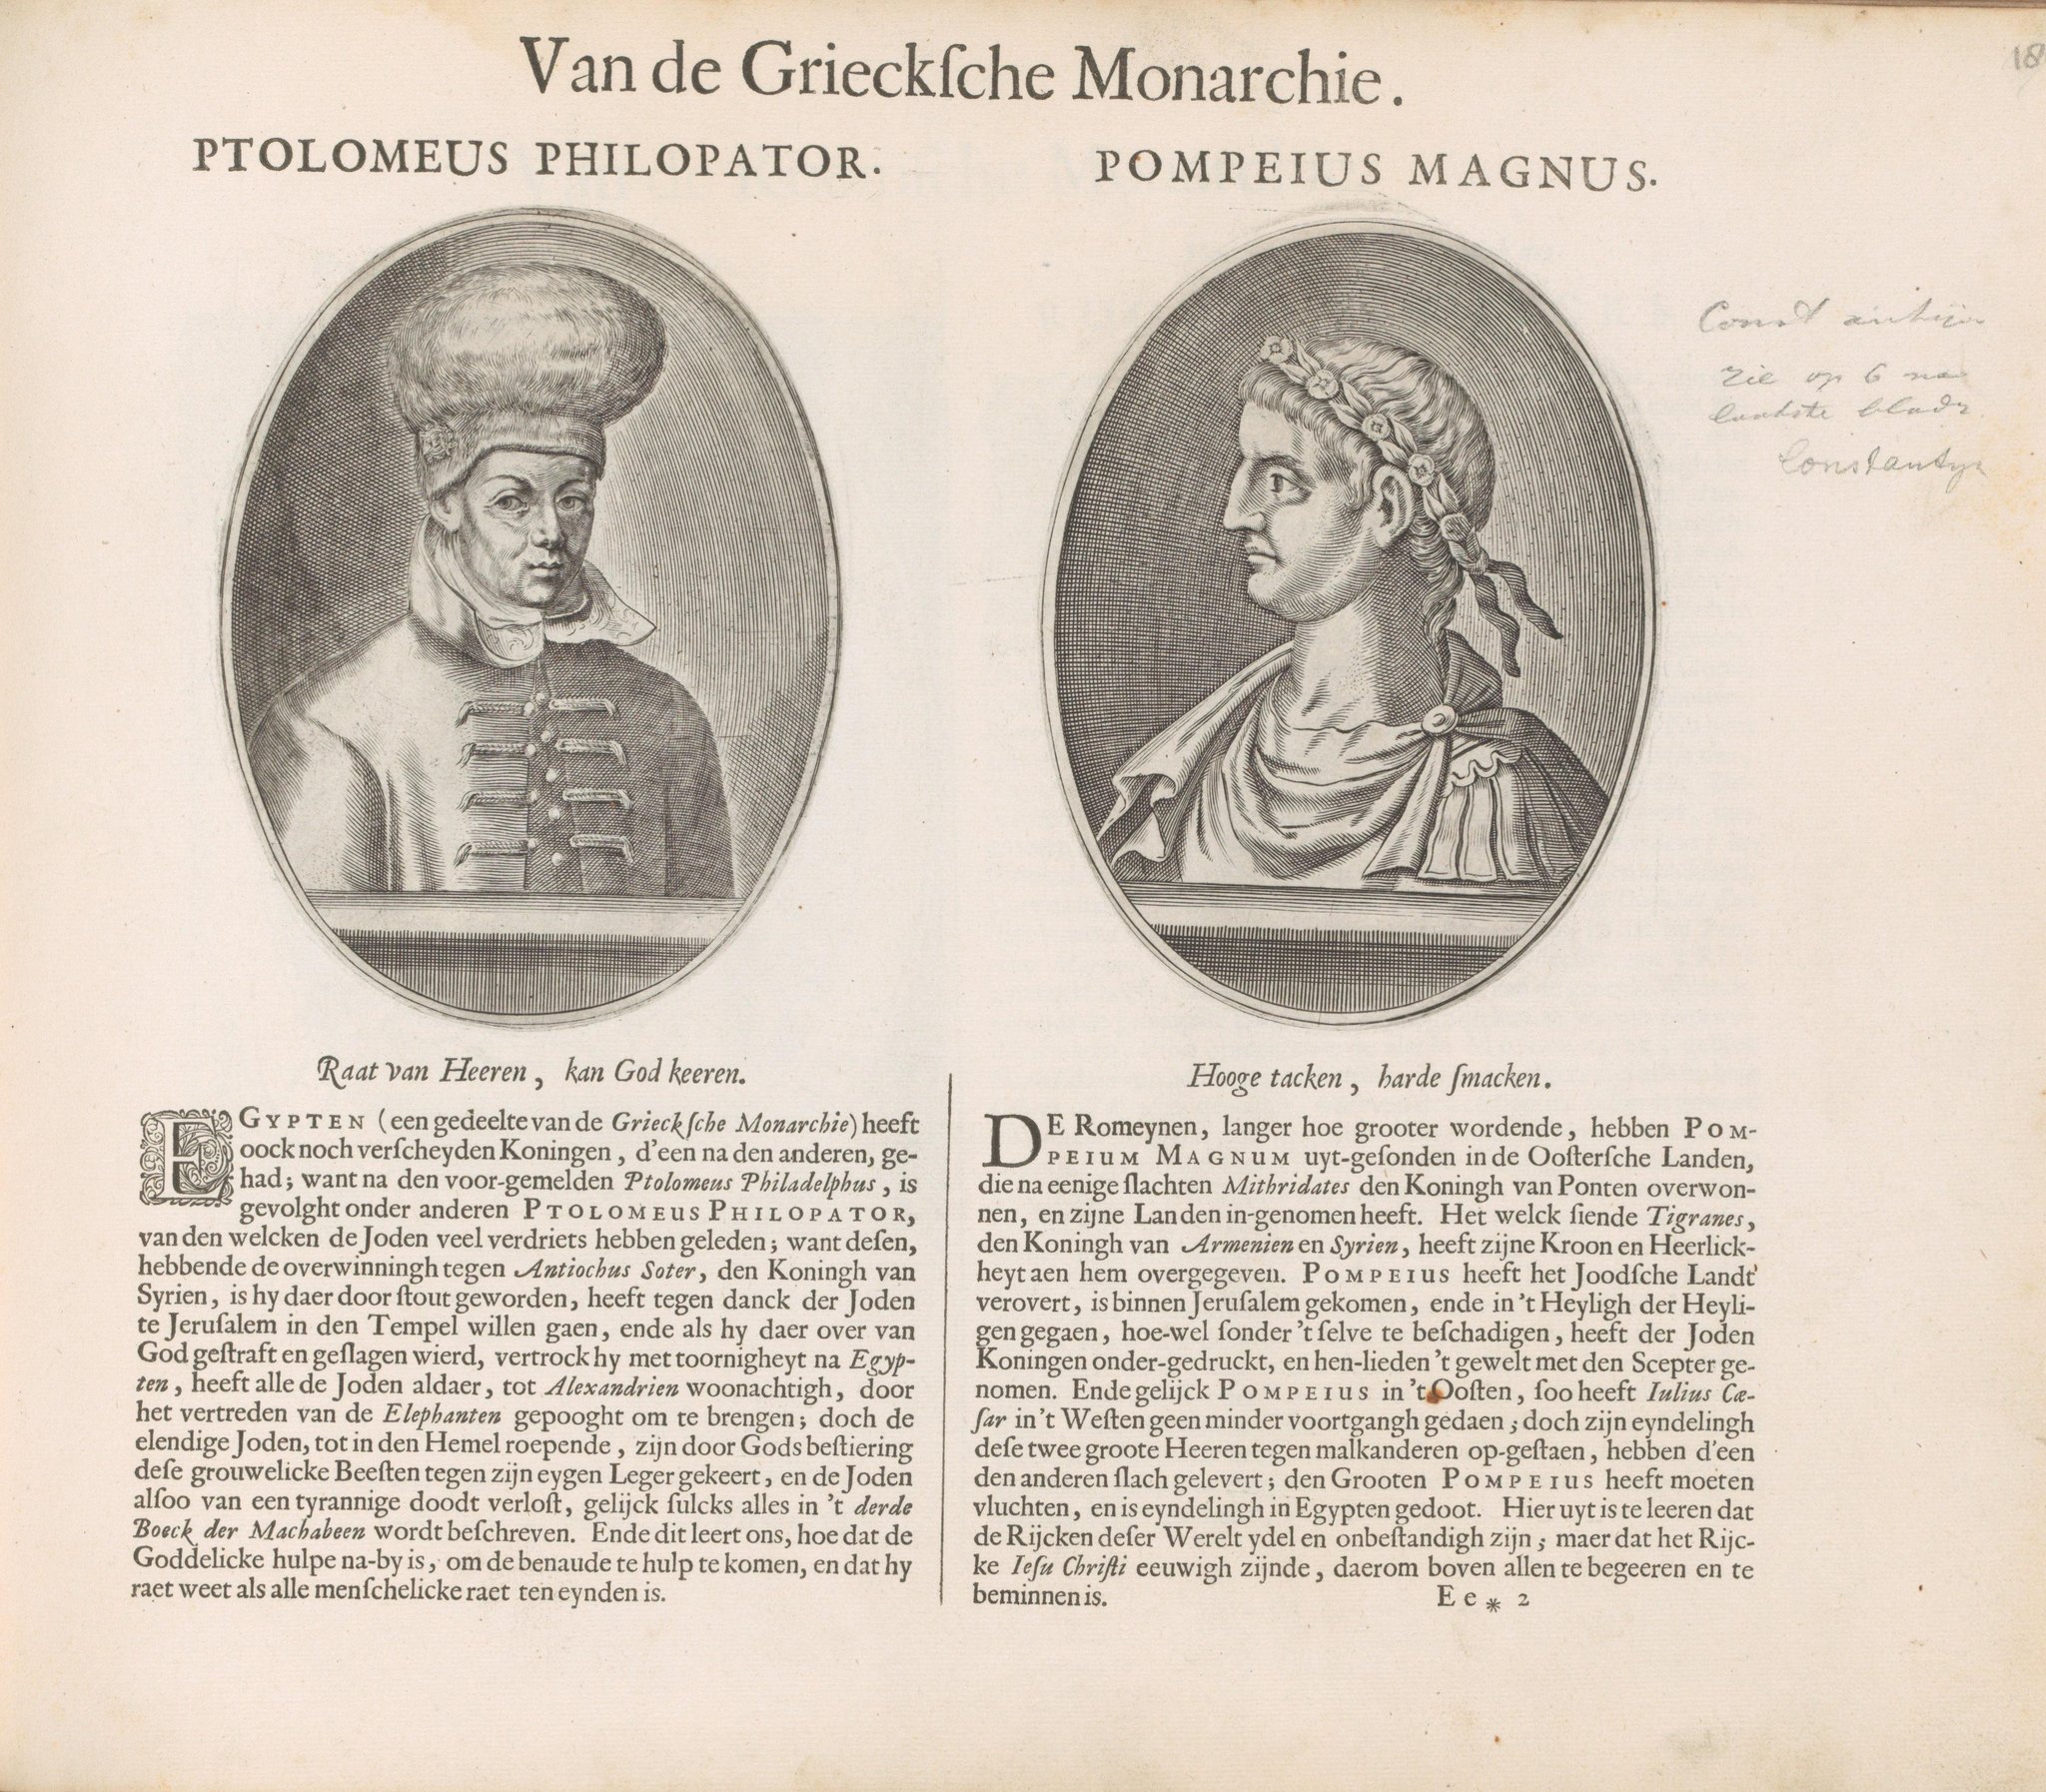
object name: album leaf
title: Portretten van Ptolemaeus IV Philopator en Pompeius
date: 1610-1625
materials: paper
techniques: engraving, letterpress printing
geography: amsterdam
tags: rome, politician, historical persons, ruler, sovereign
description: Beide portretten werden mogelijk oorspronkelijk uitgegeven door Nicolaes de Clerck in de periode 1610-1625.